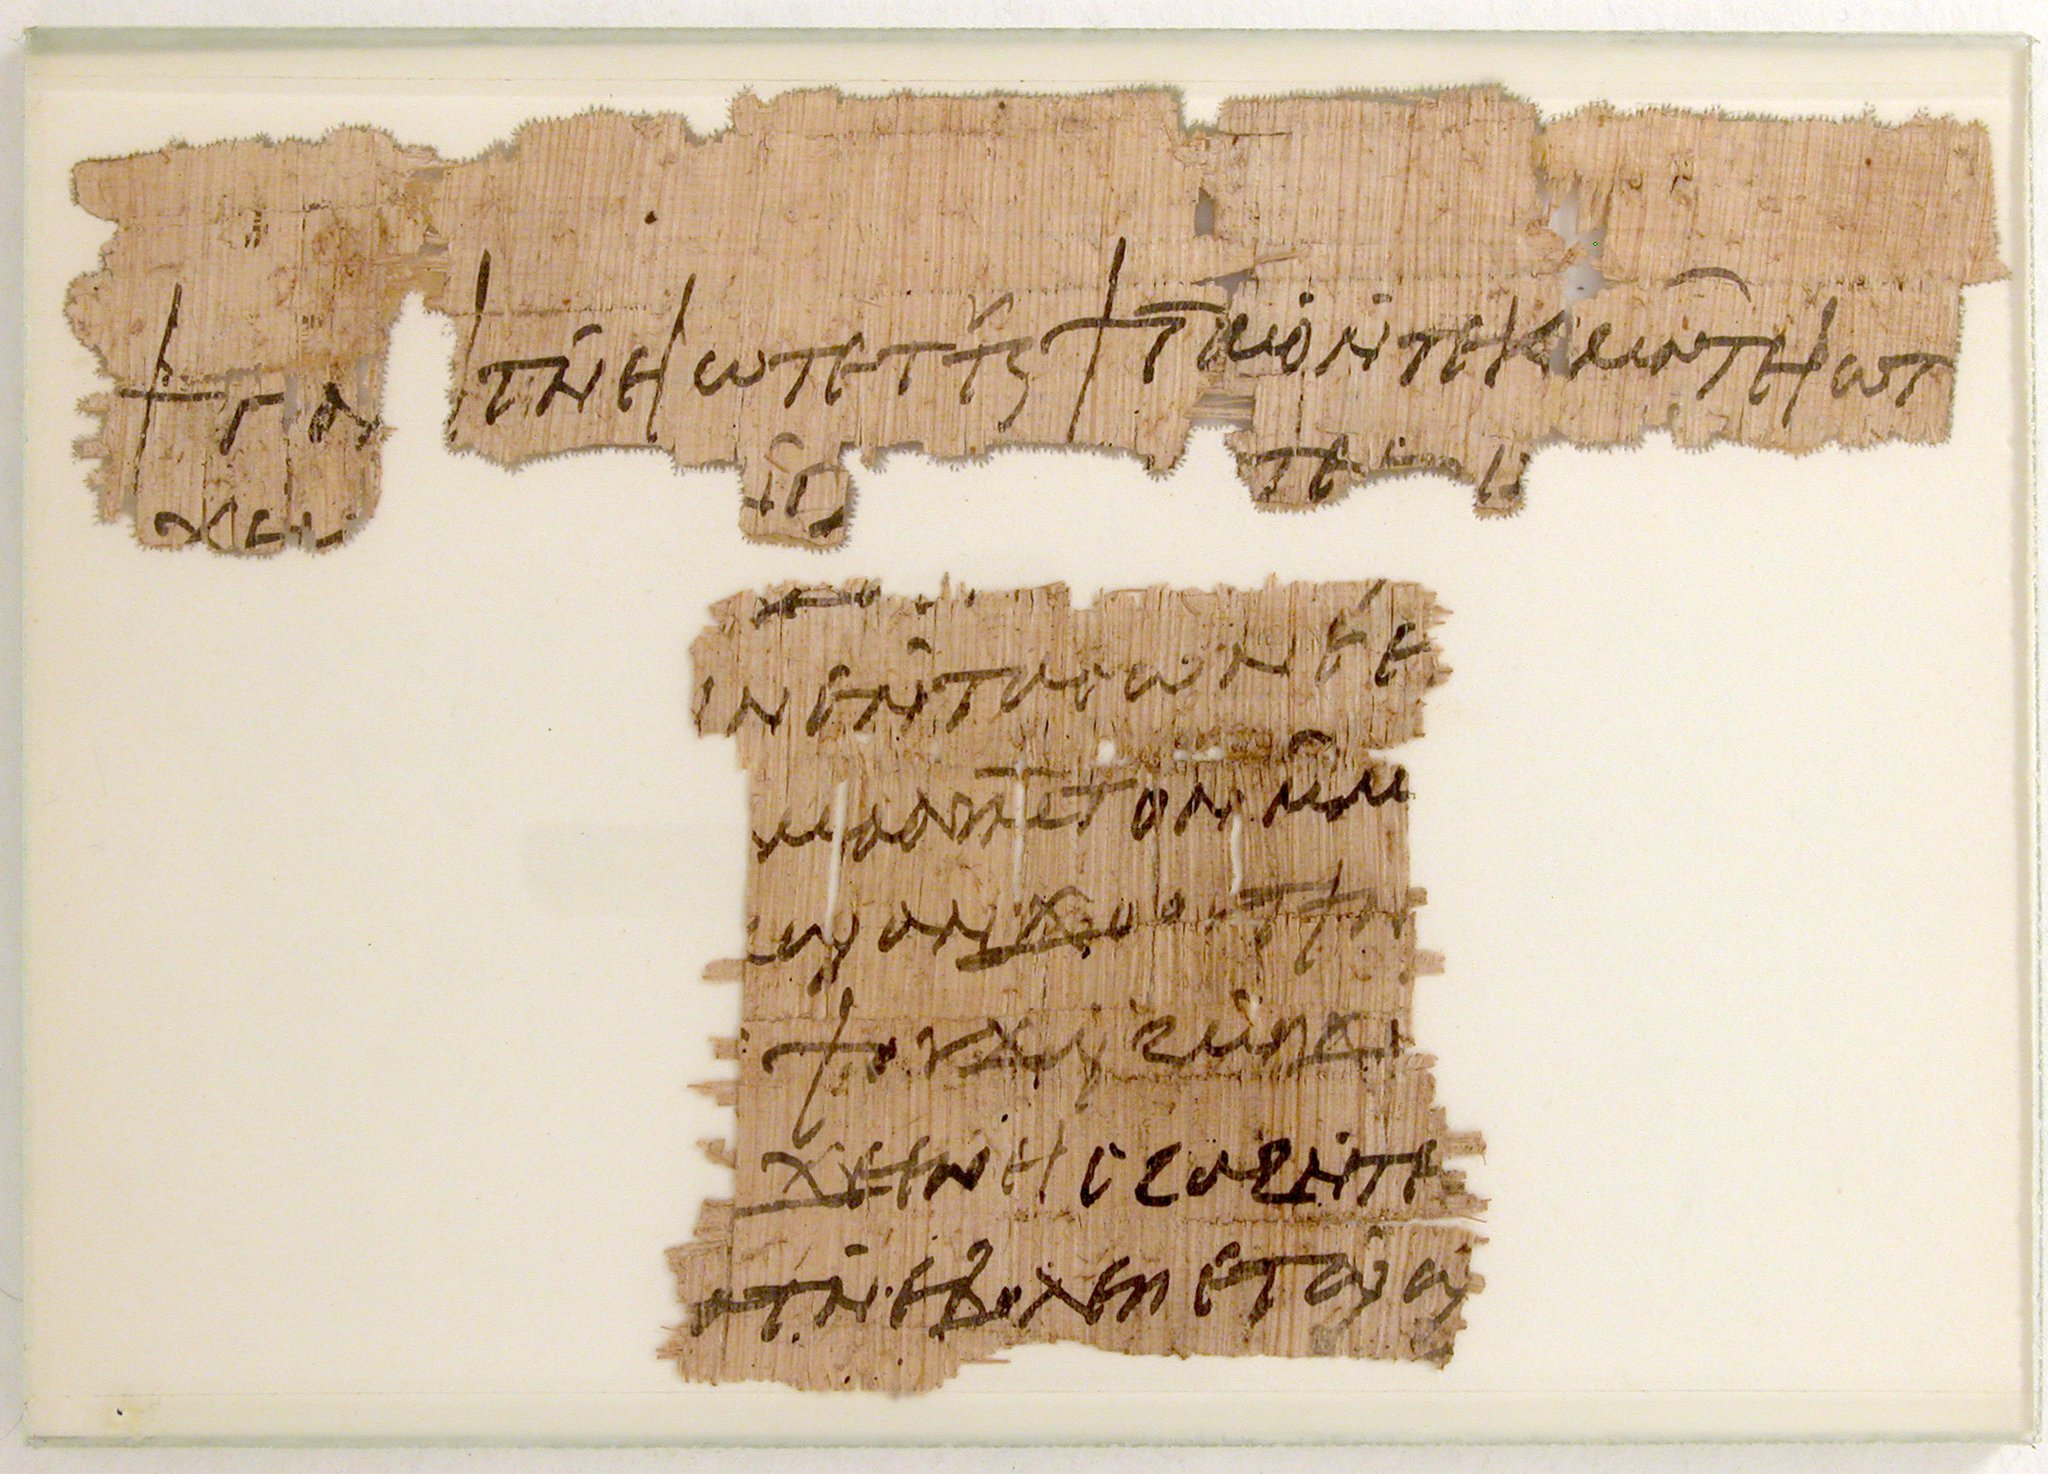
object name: fragment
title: Papyri Fragments of a Letter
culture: coptic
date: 601-700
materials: ink, papyrus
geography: egypt